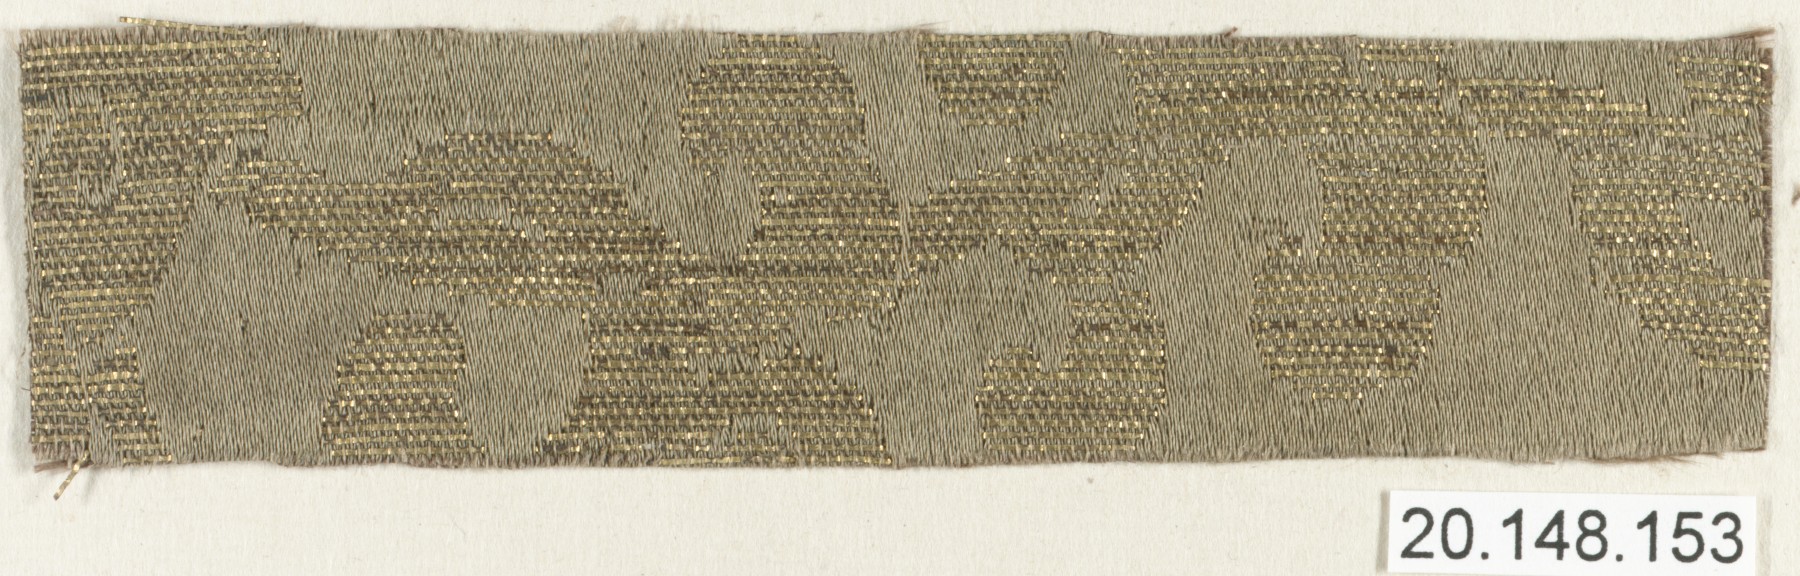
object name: piece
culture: japanese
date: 1601-1700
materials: silk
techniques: compound weave